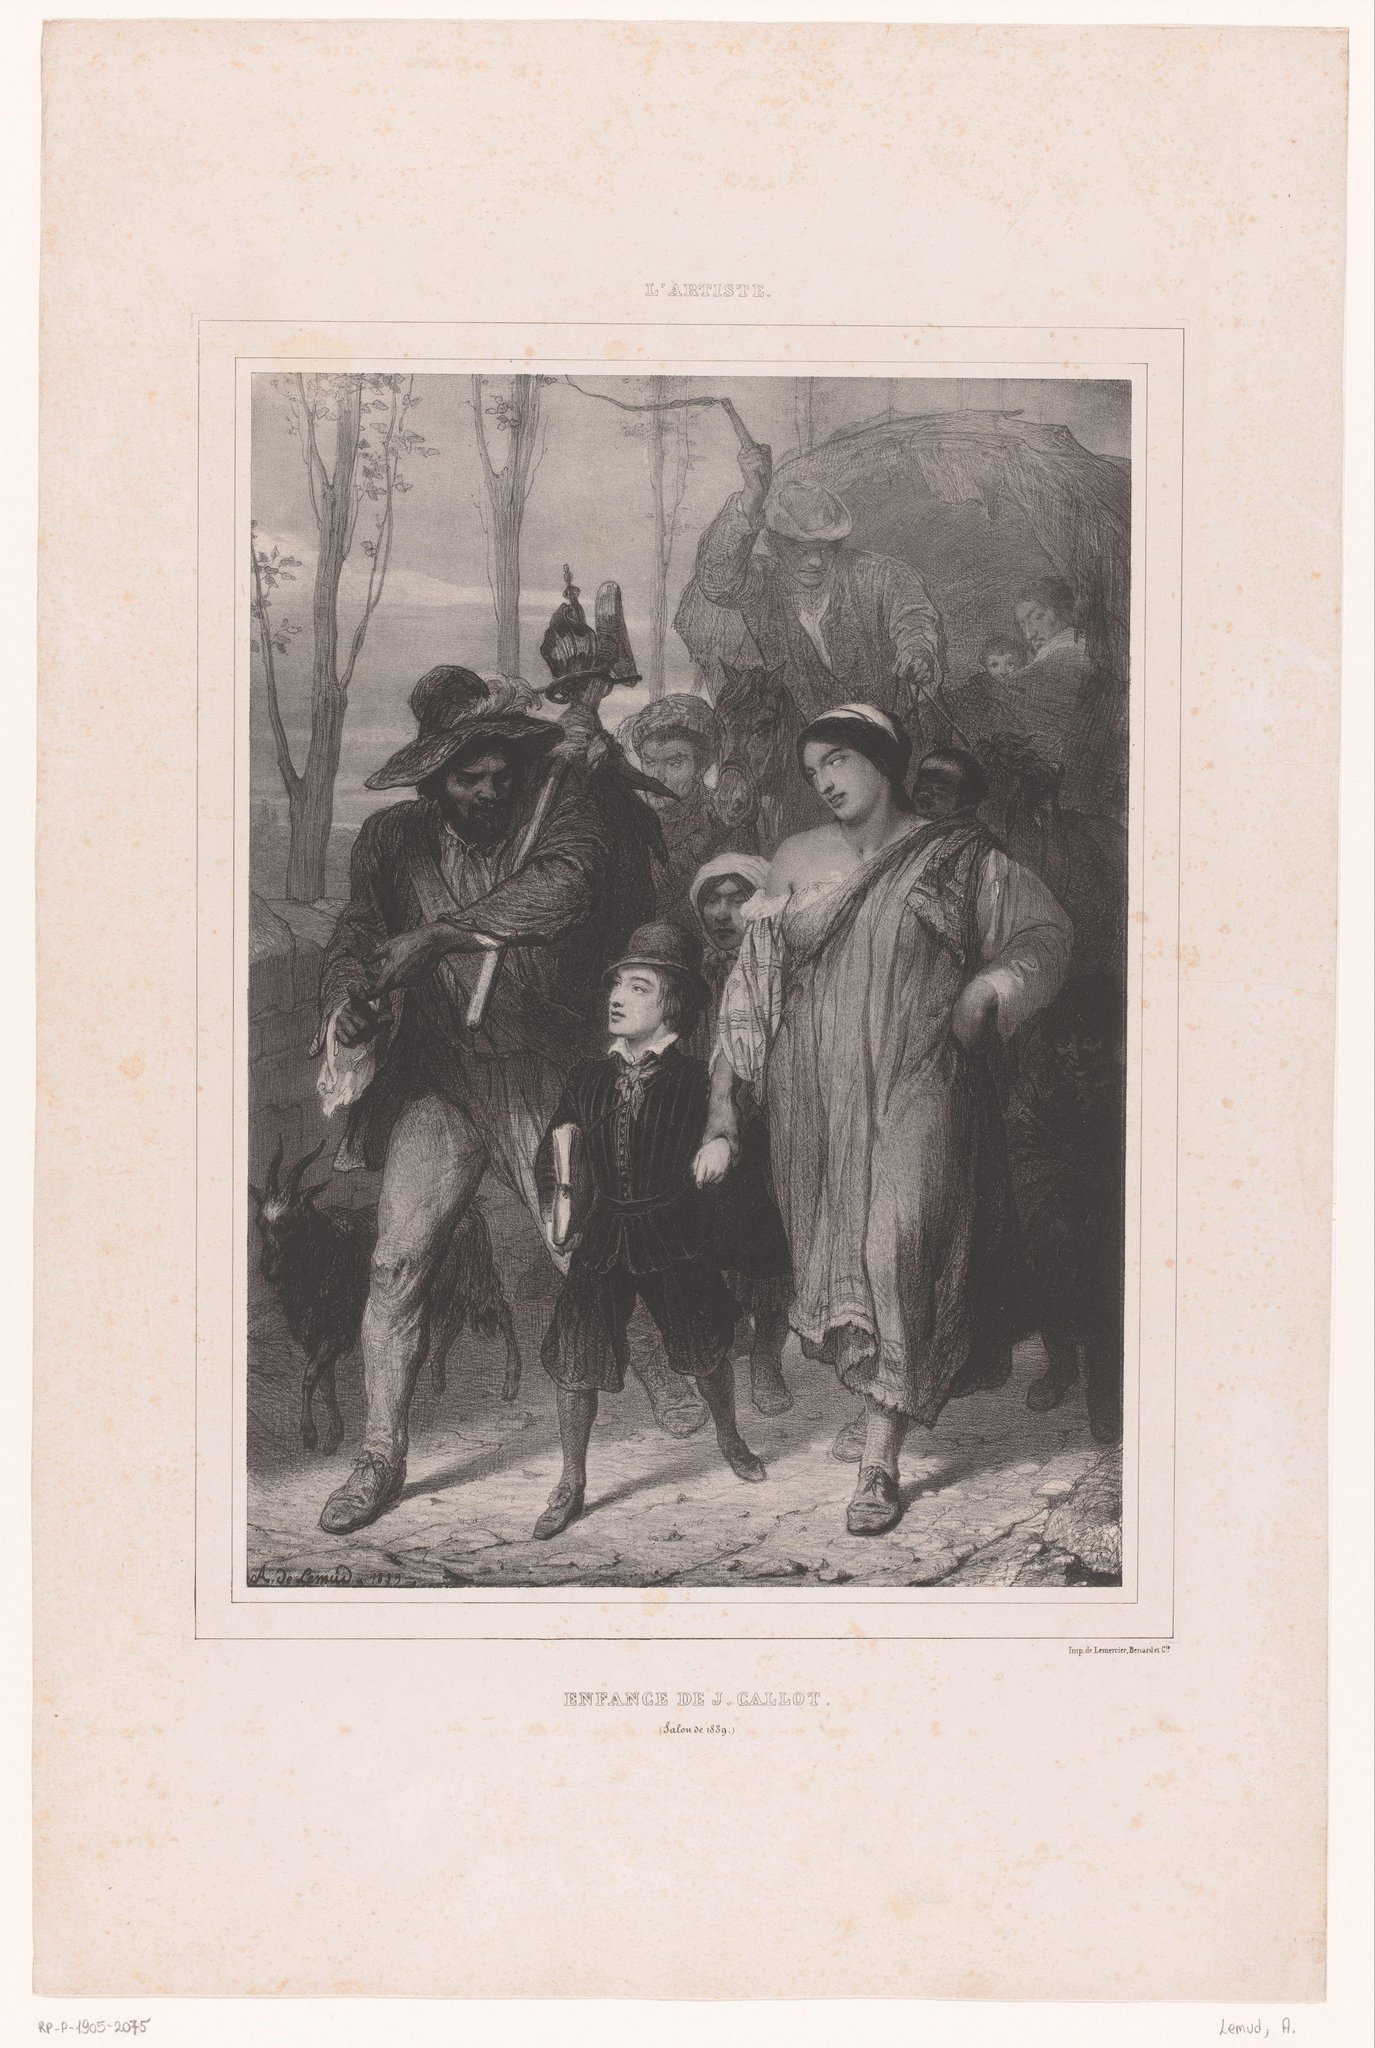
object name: print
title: Jacques Callot als kind op reis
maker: aimé de lemud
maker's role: print maker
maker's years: 1816-1887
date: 1839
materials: paper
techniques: lithography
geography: paris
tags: print maker, draughtsman, jacques callot, boy (child between toddler and youth), historical persons, 'en route', traveller under way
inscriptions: collector's mark: Lugt 2228a